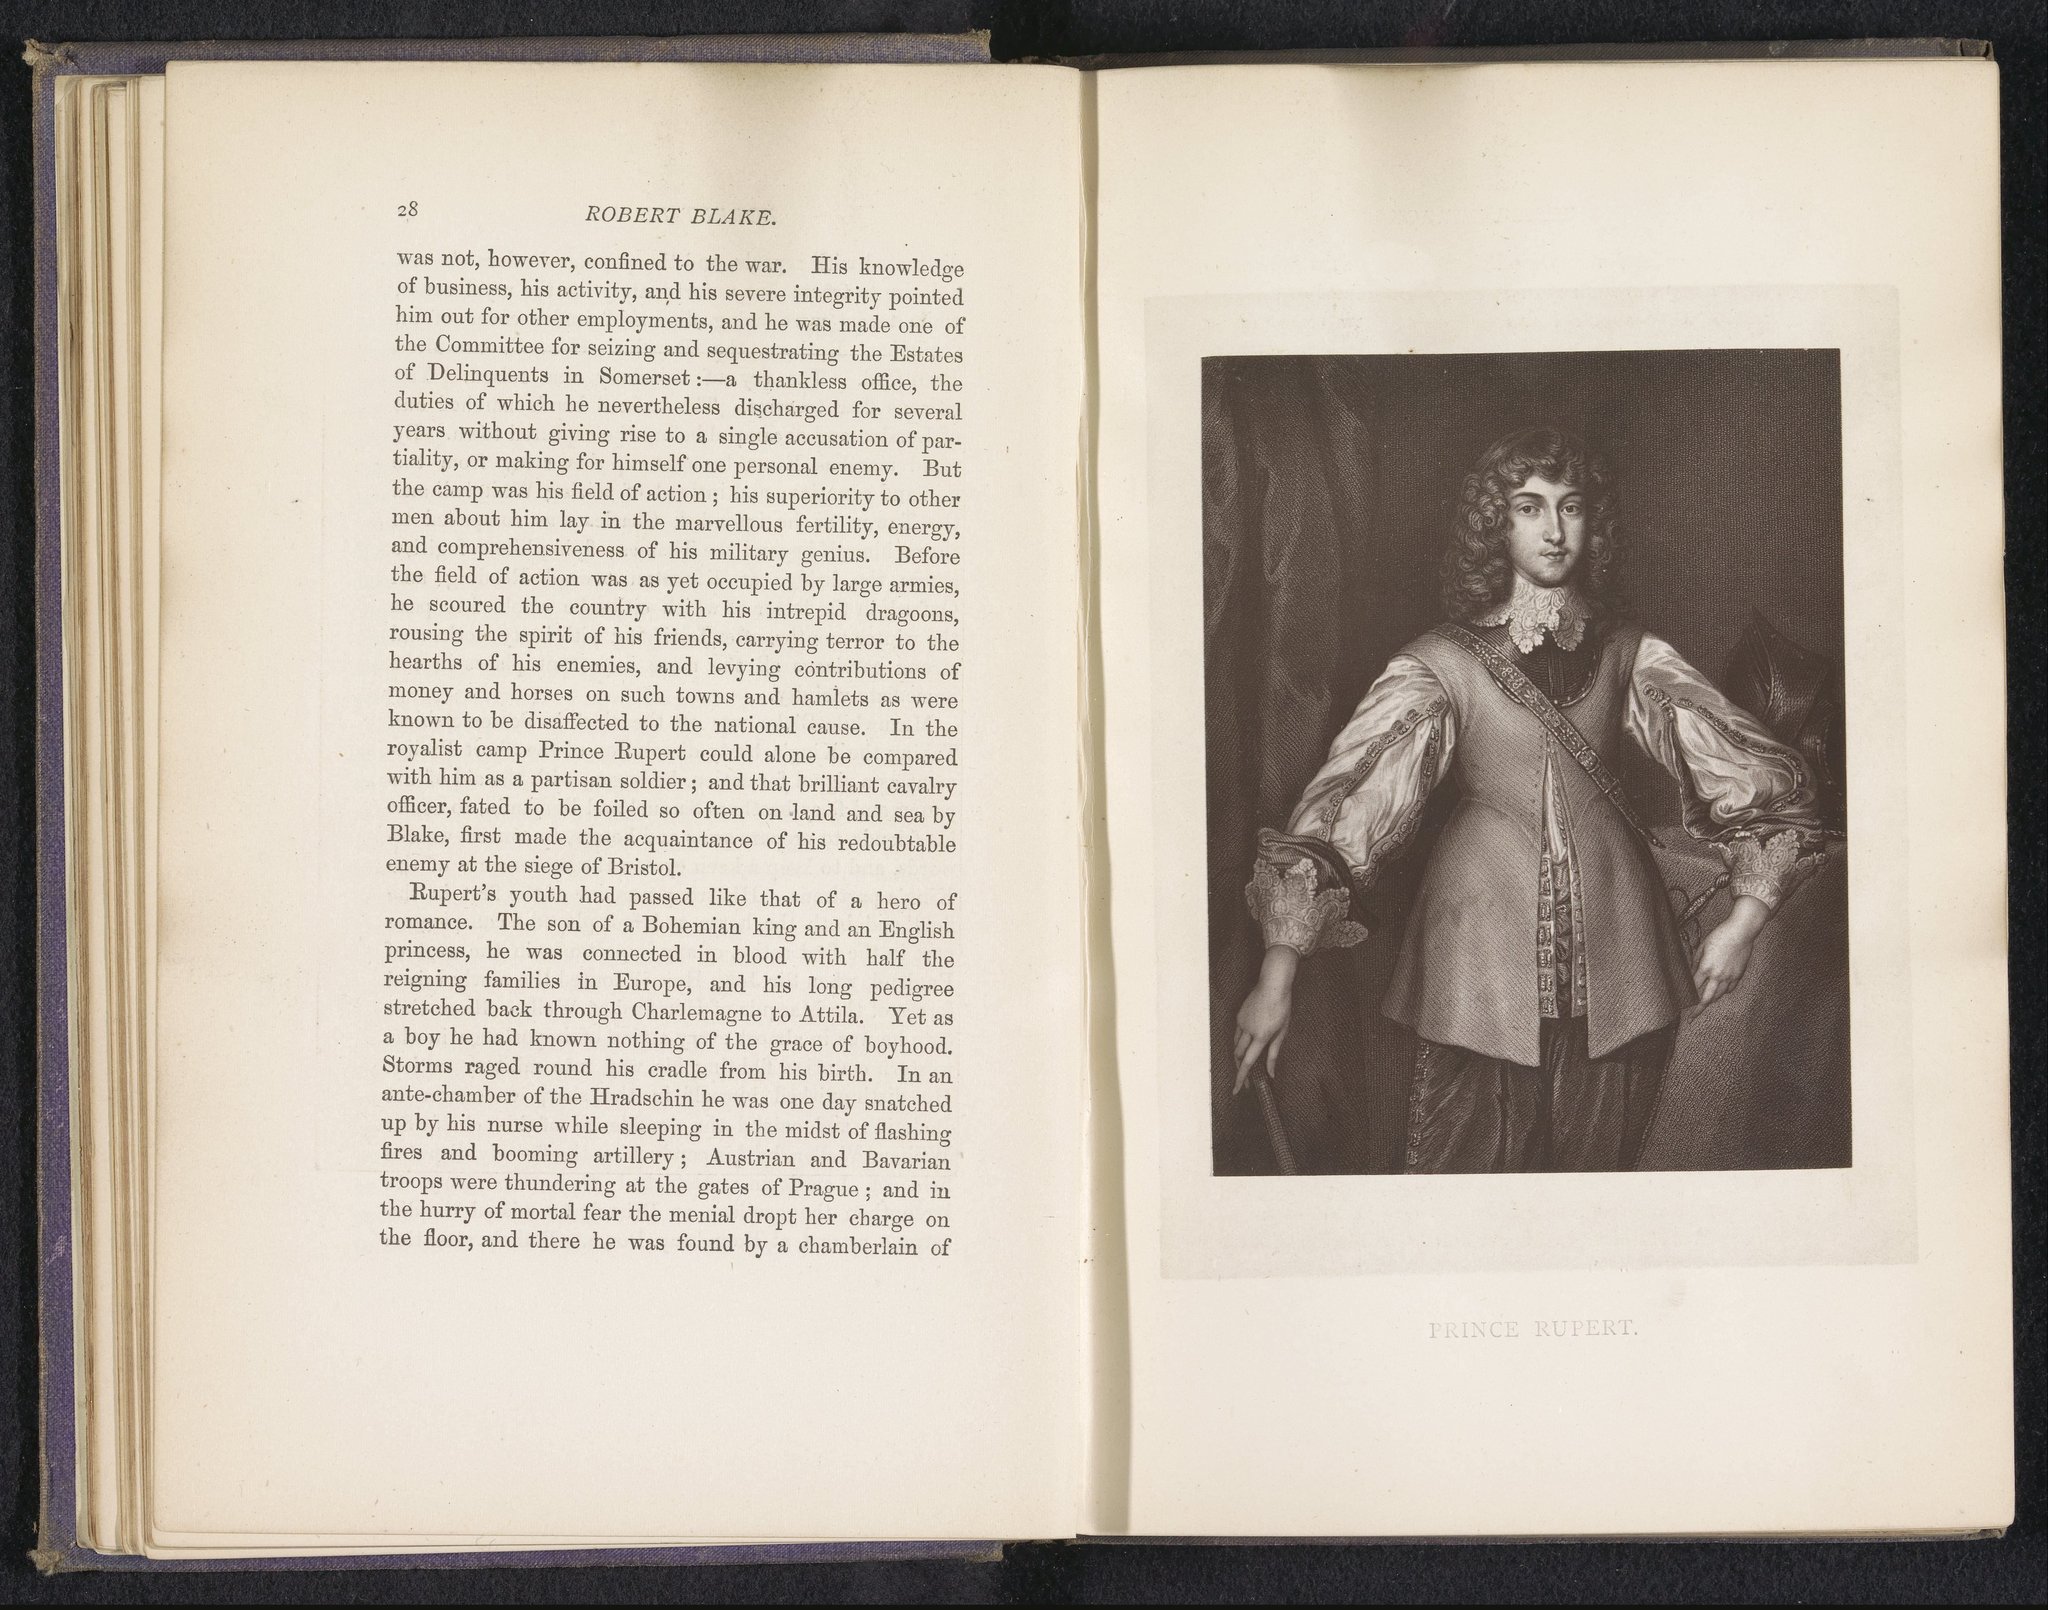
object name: page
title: Prince Rupert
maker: Anonymous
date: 1875-1885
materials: paper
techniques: woodburytype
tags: commander-in-chief, admiral